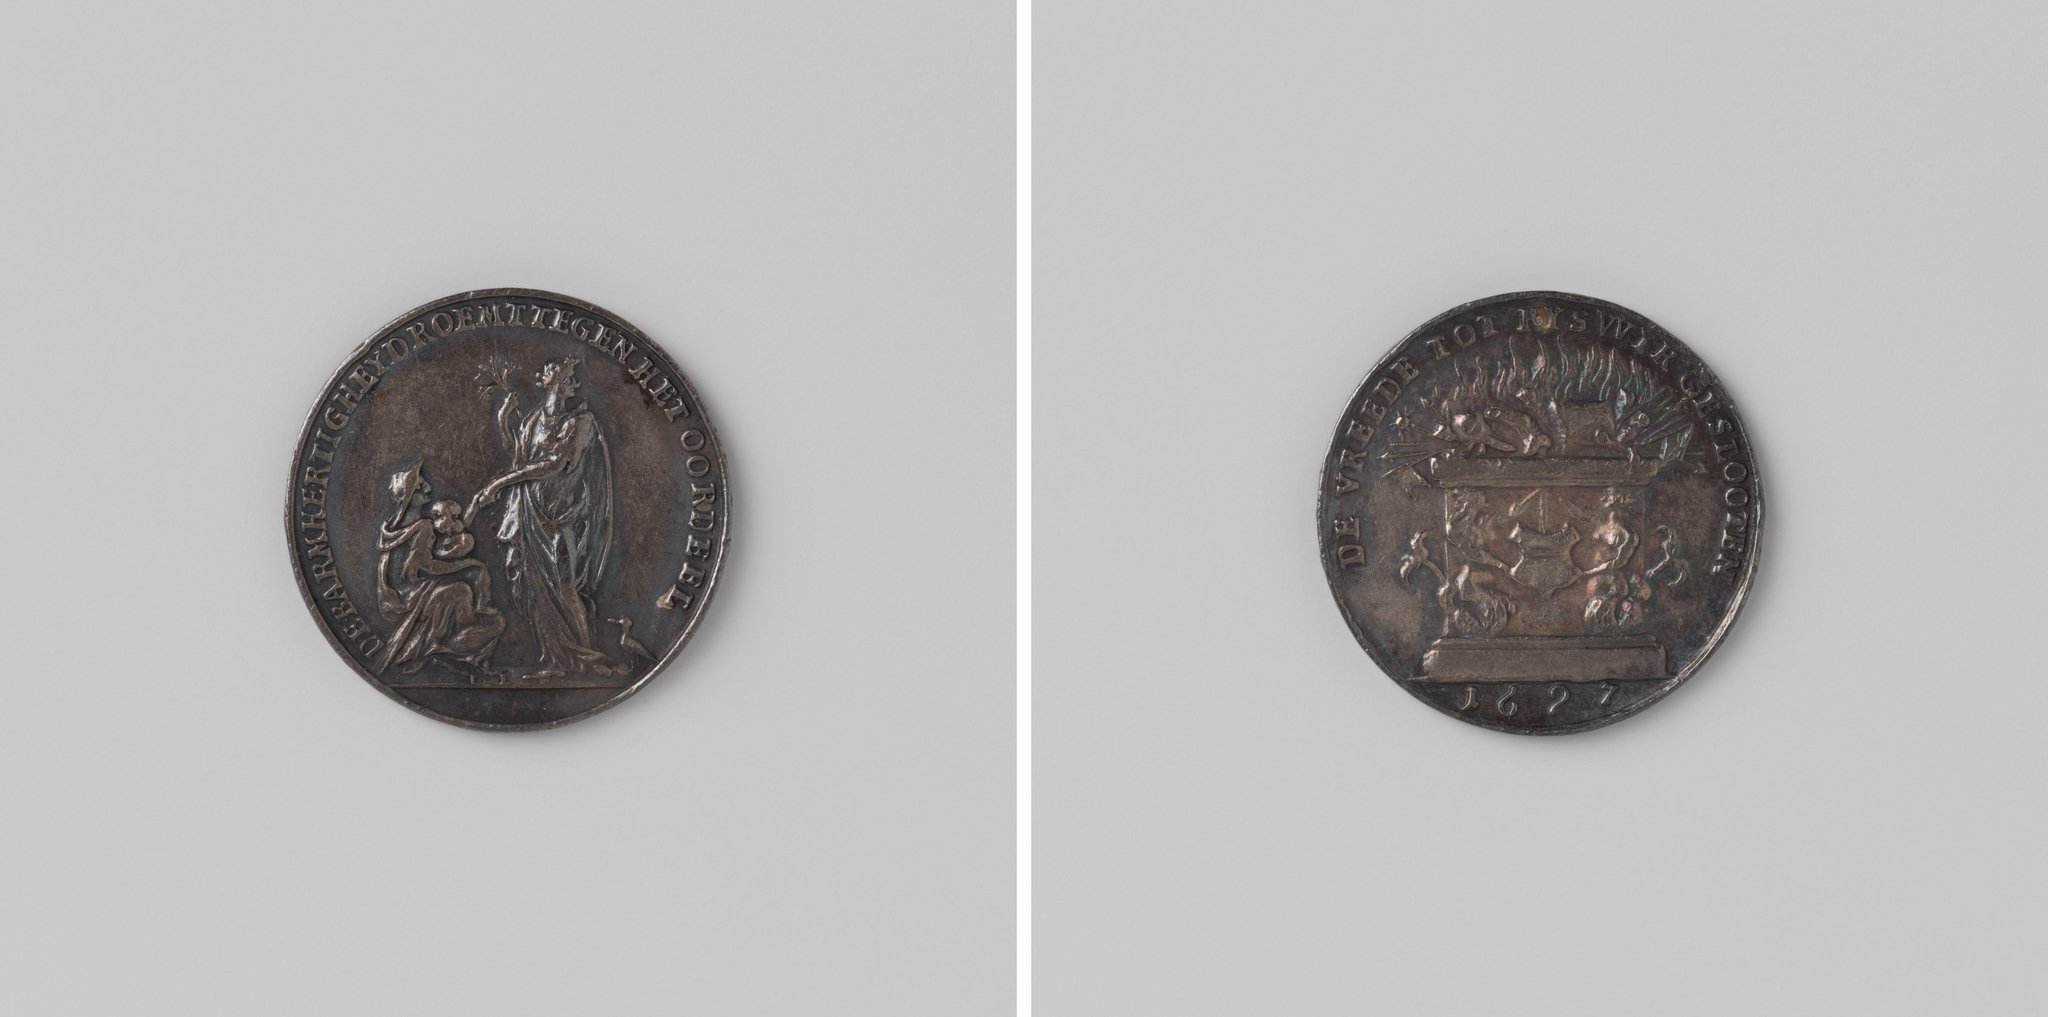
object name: medal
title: Vrede van Rijswijk, penning uitgedeeld aan ieder die in de loterij van Muiden geen prijs heeft gewonnen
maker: jan luder (i)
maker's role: medailleur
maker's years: 1648-1719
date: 1697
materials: silver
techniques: striking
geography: netherlands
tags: muiden, rijswijk, vrede van rijswijk (1697)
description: Zilveren penning. Voorzijde: Barmhartigheid met vredestak beurt bedrukte moeder met kind in de armen op, rechts een vogeltje binnen omschrift. Keerzijde: oorlogstuig brandend op een altaar, waarvoor twee meermannen wapenschild houden binnen omschrift; afsnede: jaartal